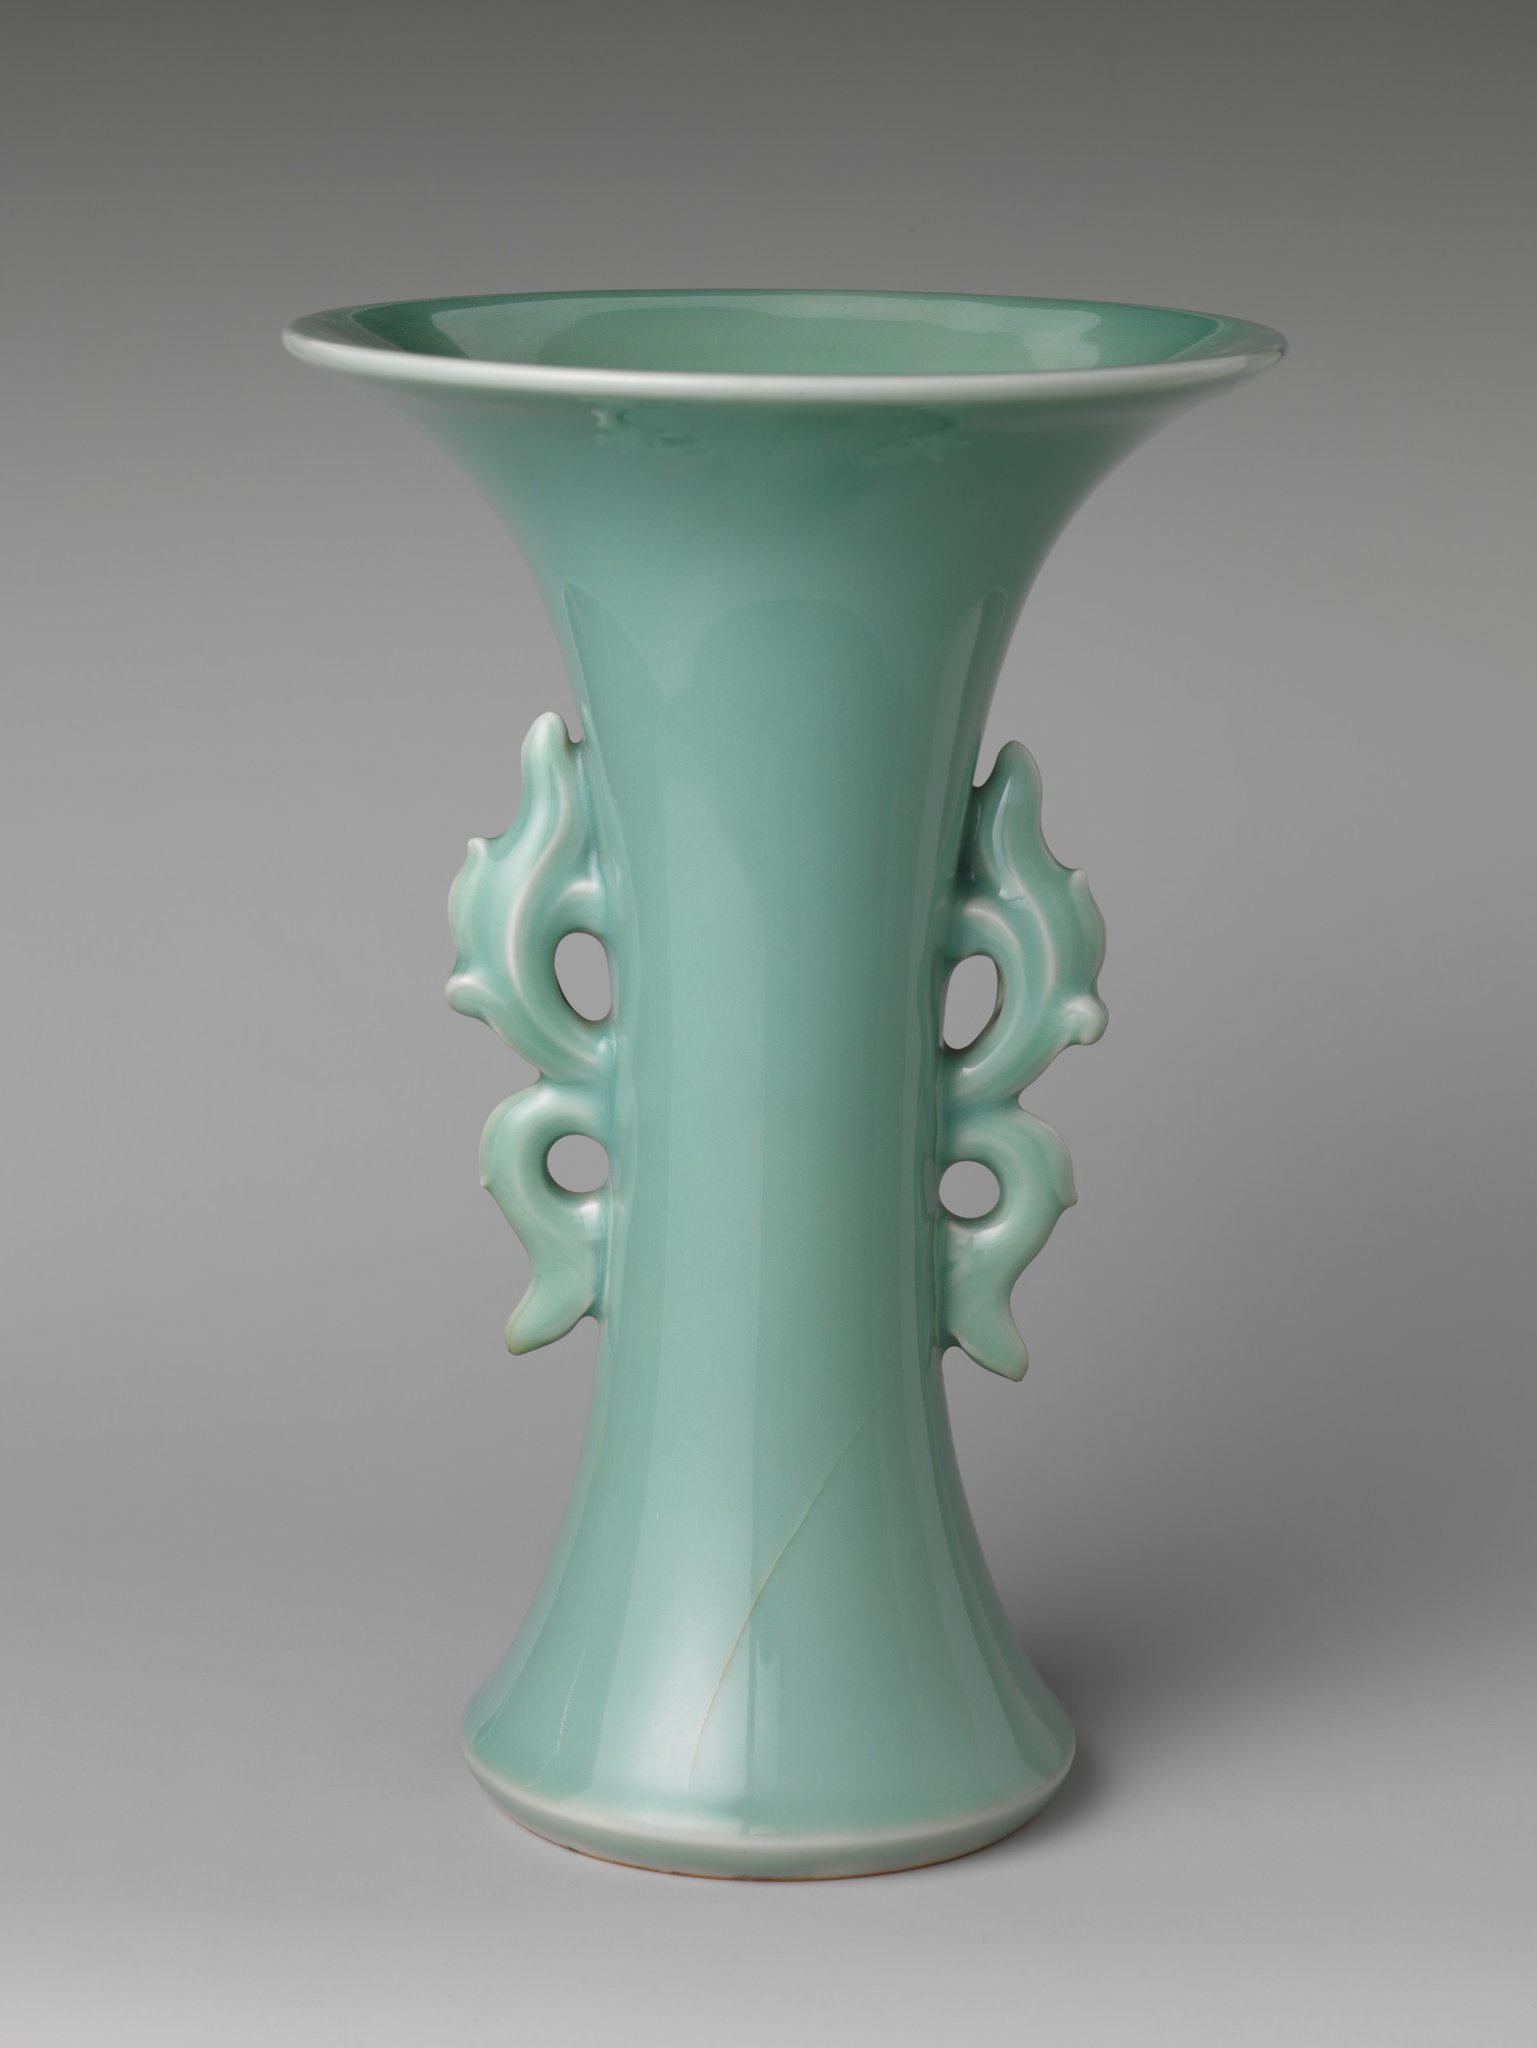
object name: vase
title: Vase in Shape of Archaic Chinese bronze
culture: japanese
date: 1751-1800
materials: ceramic glaze, glaze, porcelain